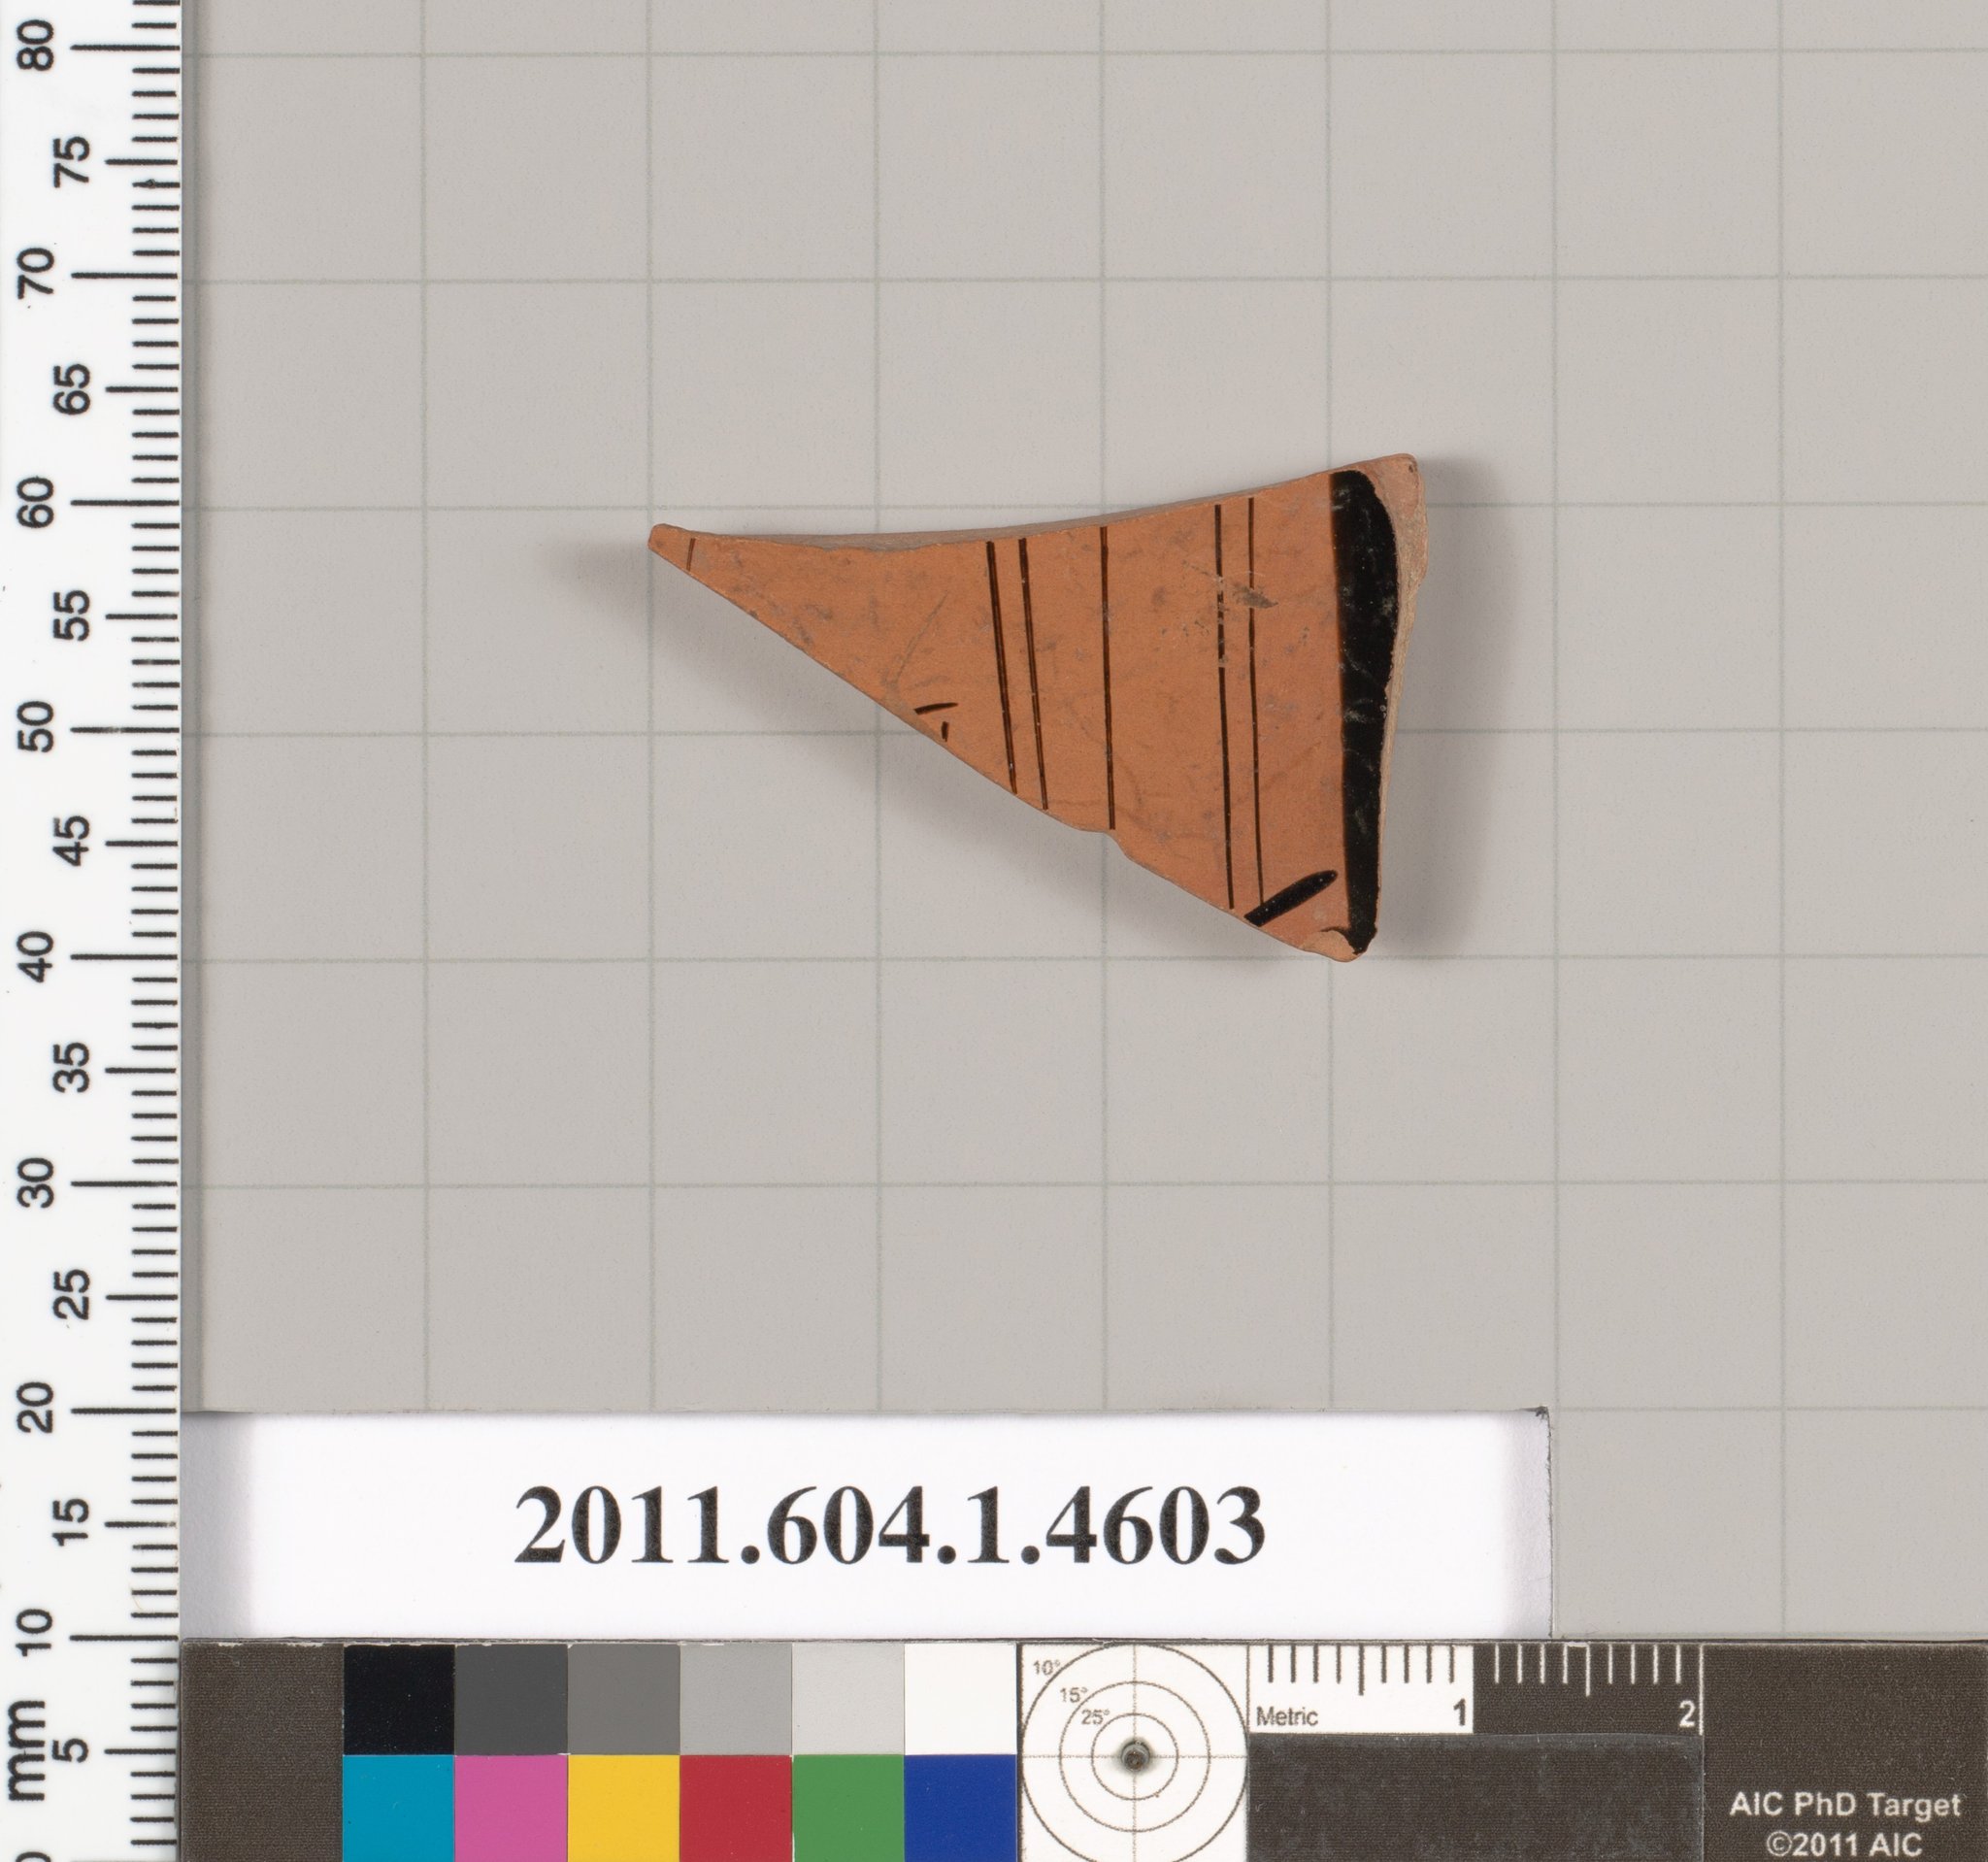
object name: kylix fragment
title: Terracotta fragment of a kylix (drinking cup)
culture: greek, attic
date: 475-451 BCE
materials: terracotta